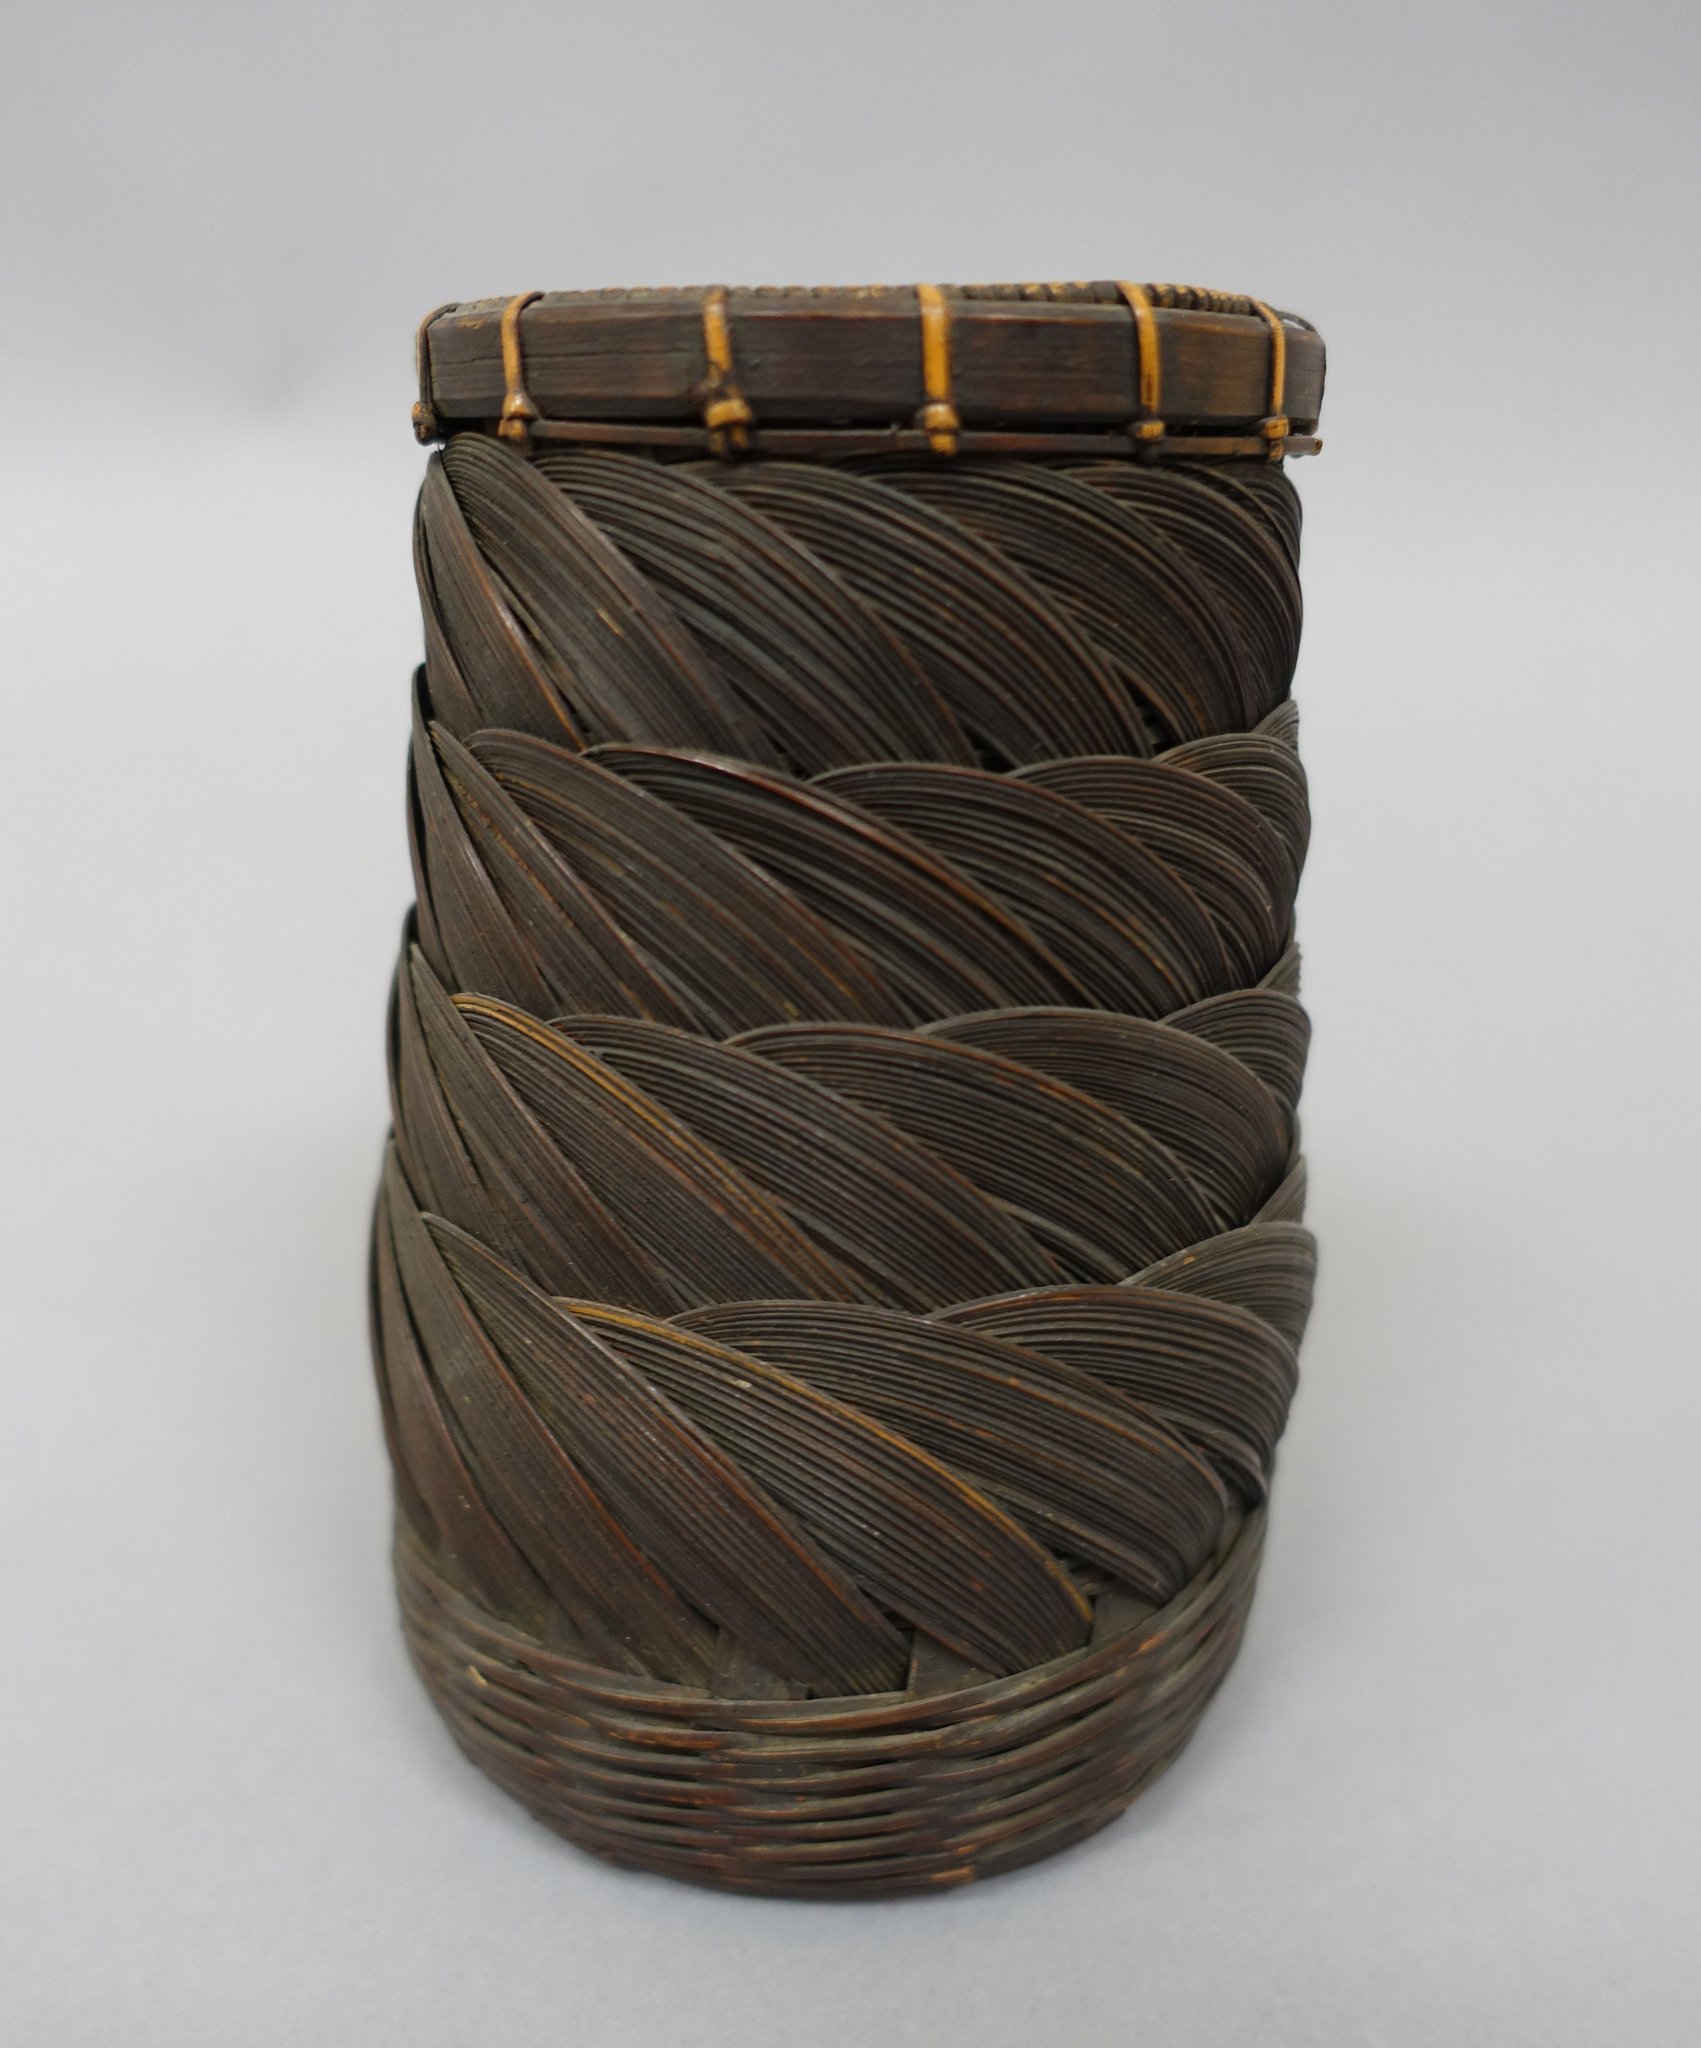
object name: basket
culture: japanese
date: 1801-1900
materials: bamboo